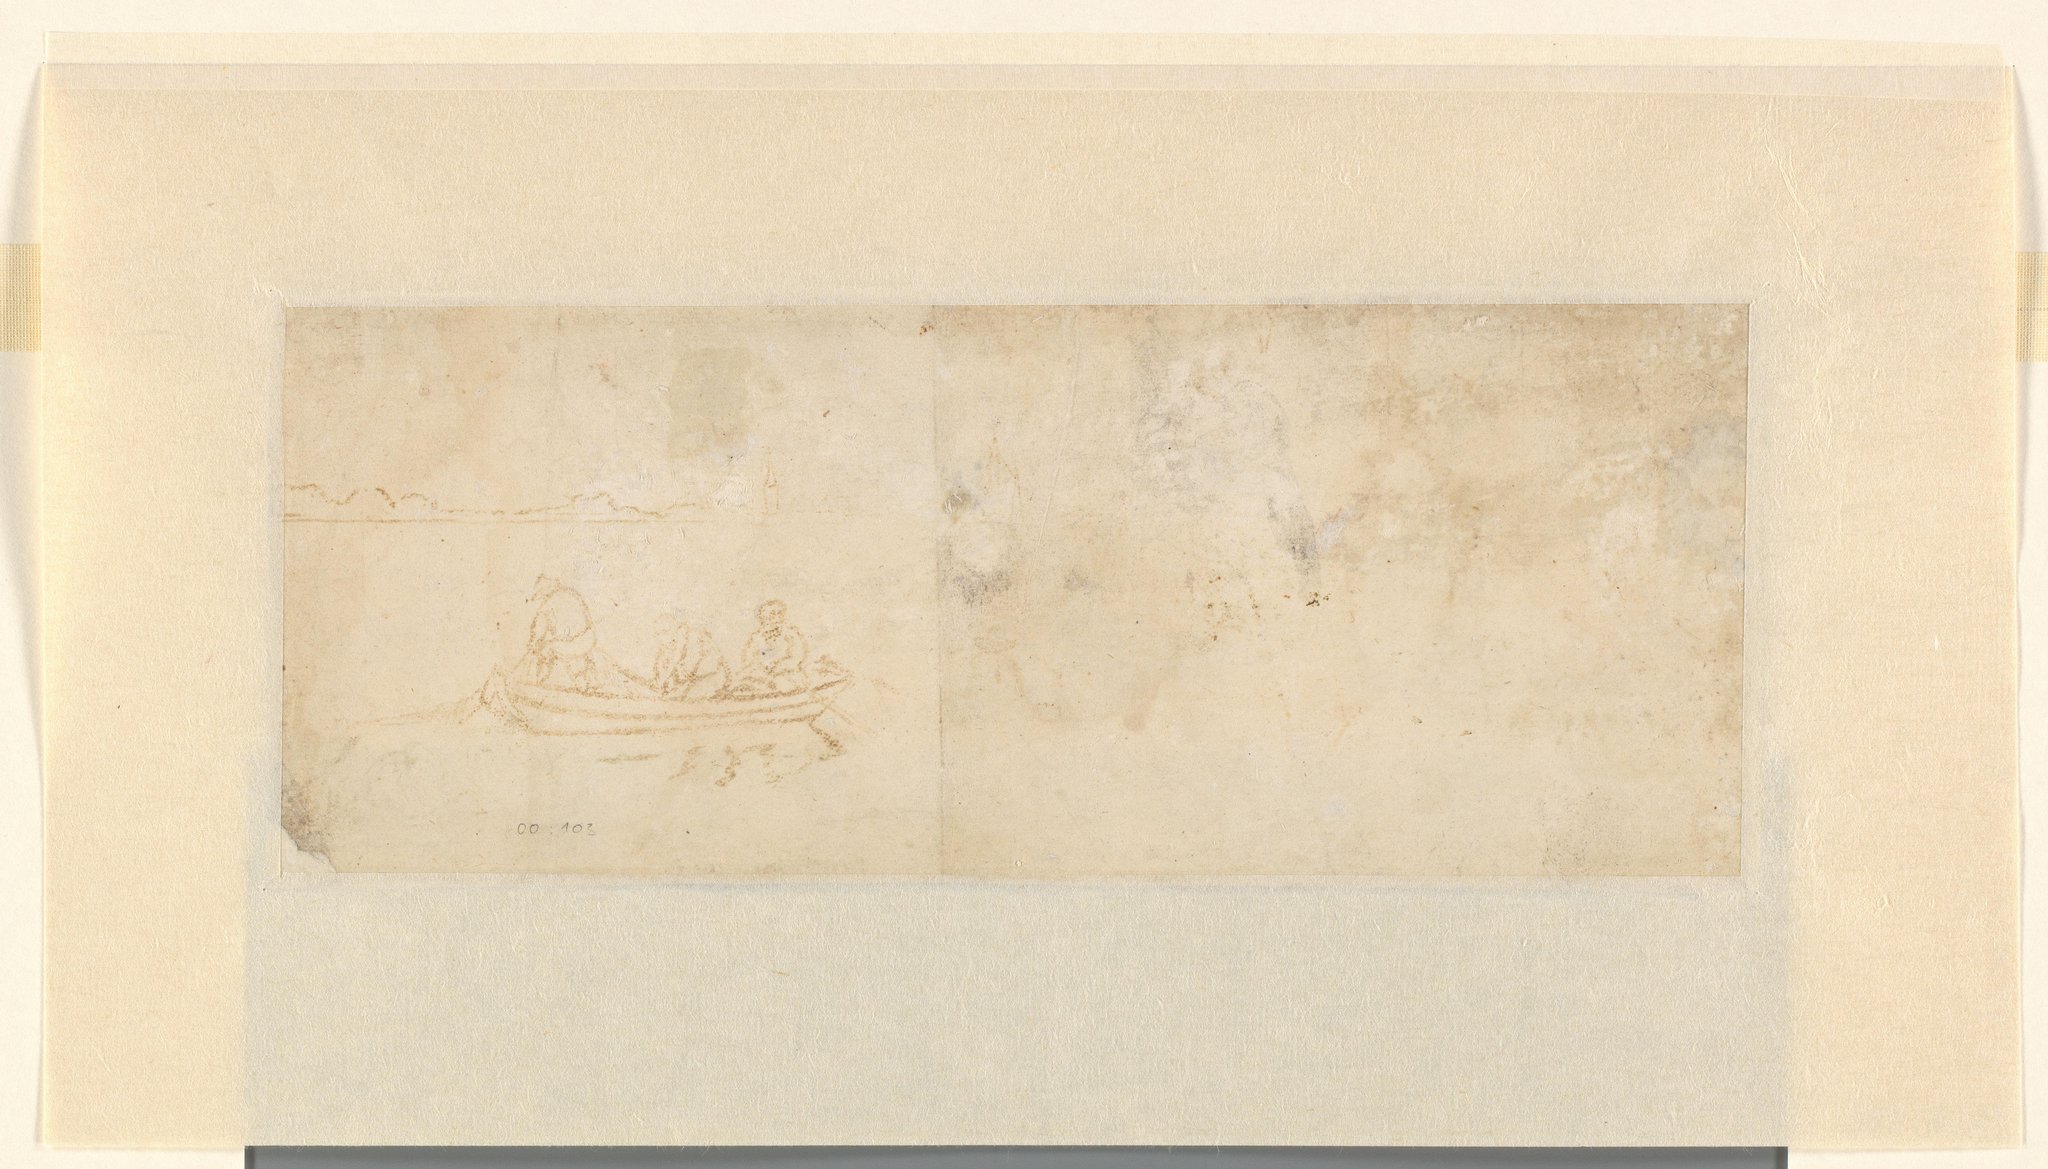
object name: drawing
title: Schets van drie vissers in een roeibootje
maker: pieter coopse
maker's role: draughtsman, print maker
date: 1668-1677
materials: chalk, paper